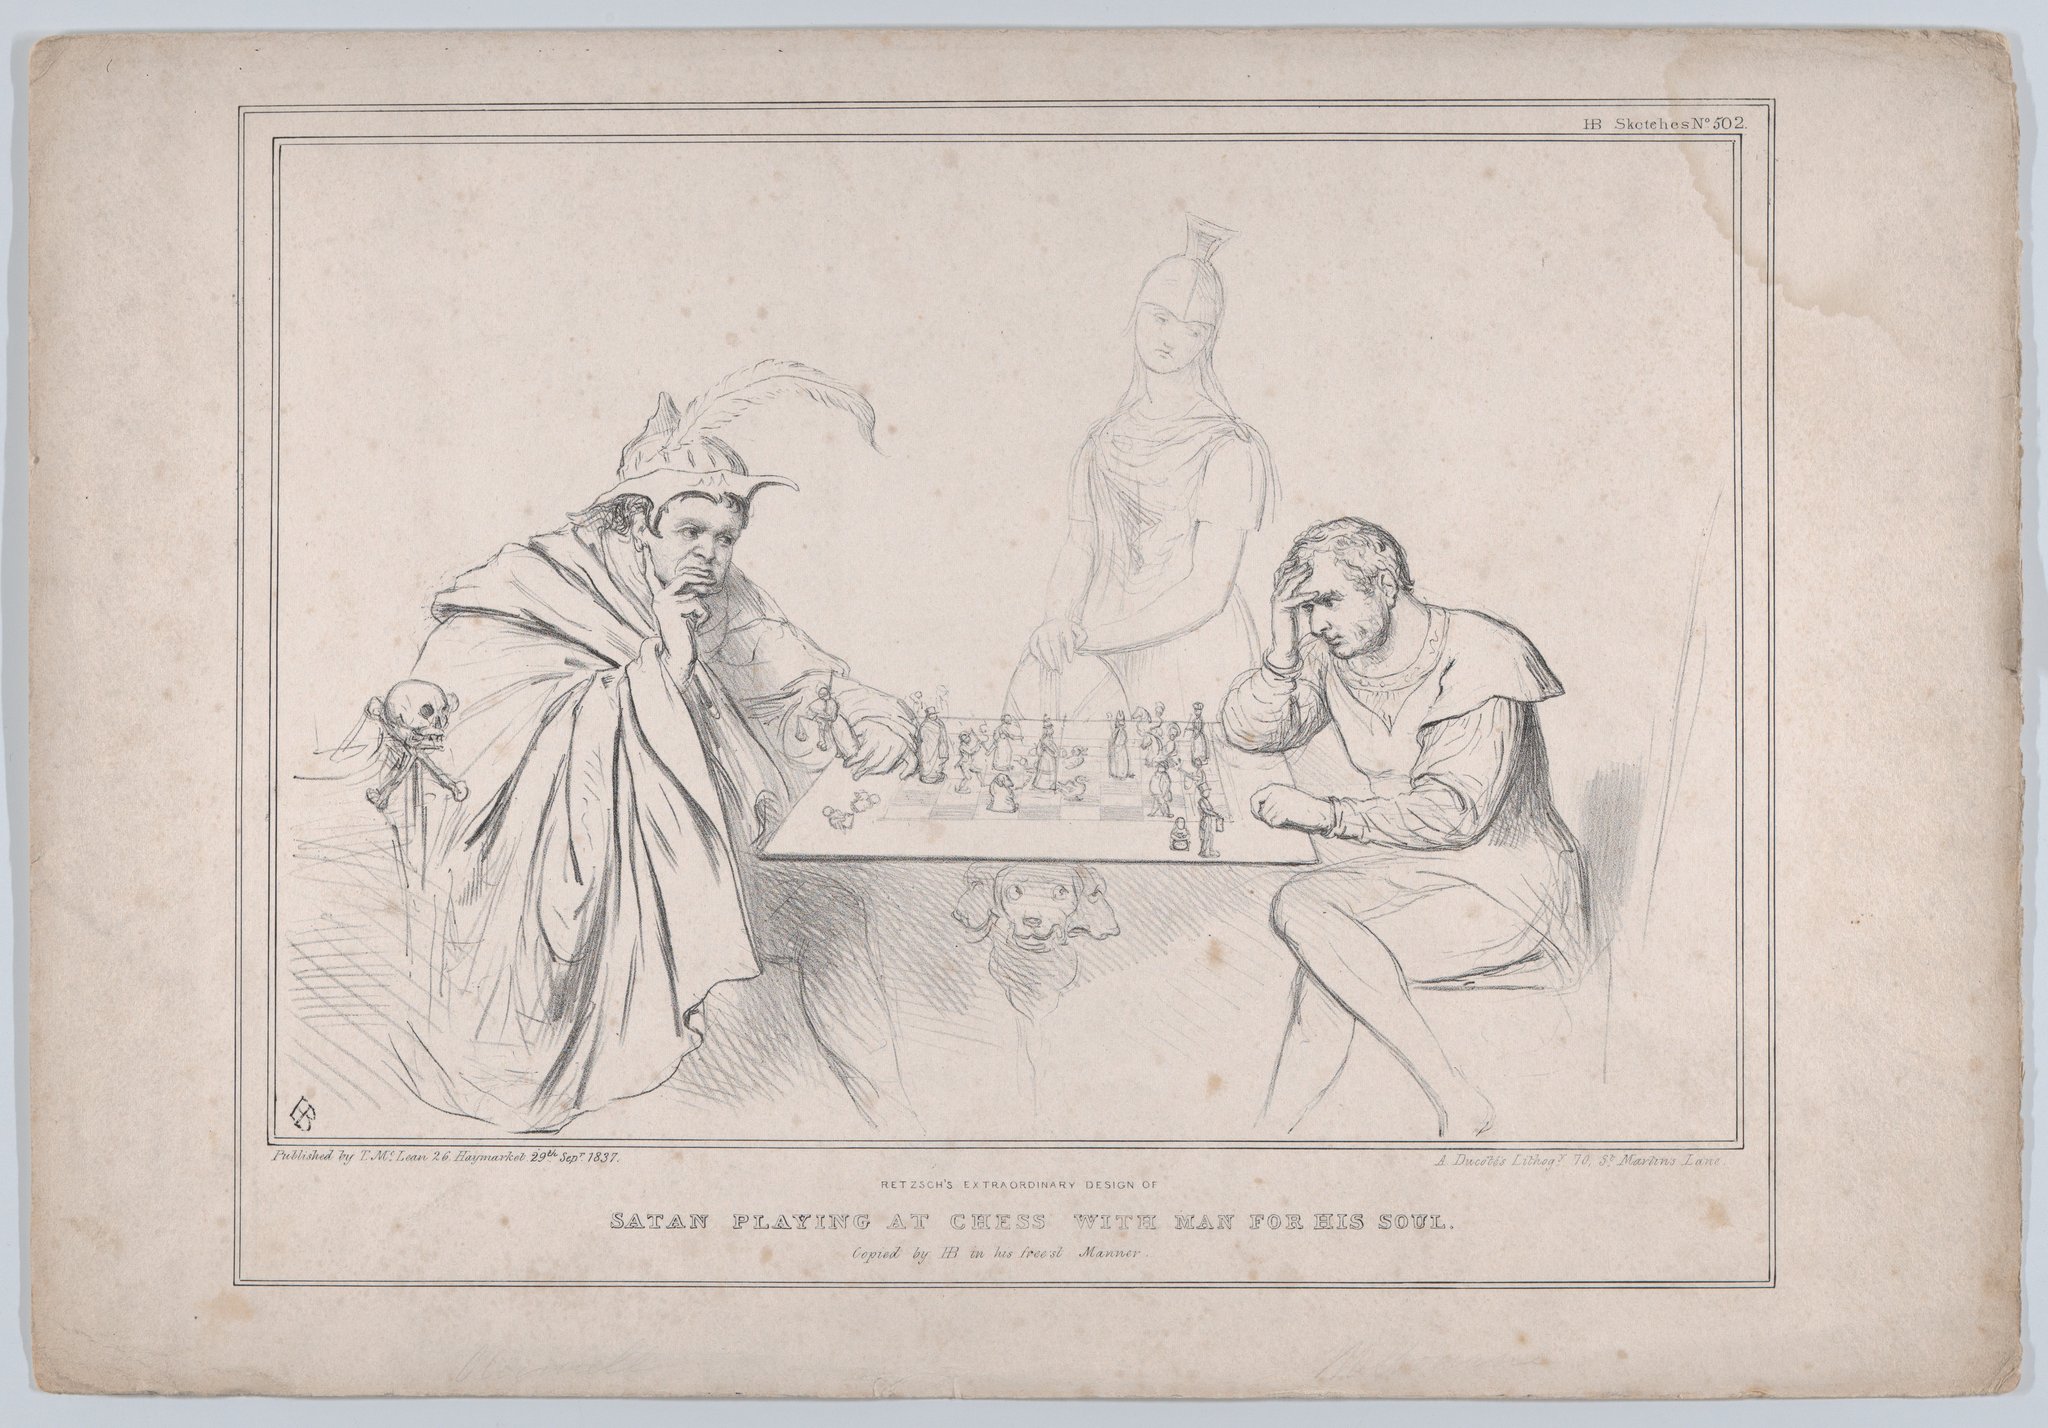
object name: print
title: Retzsch's Extraordinary Design of Satan Playing at Chess with Man for his Soul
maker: john doyle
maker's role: artist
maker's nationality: irish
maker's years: 1797-1868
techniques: lithograph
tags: men,chess,devil